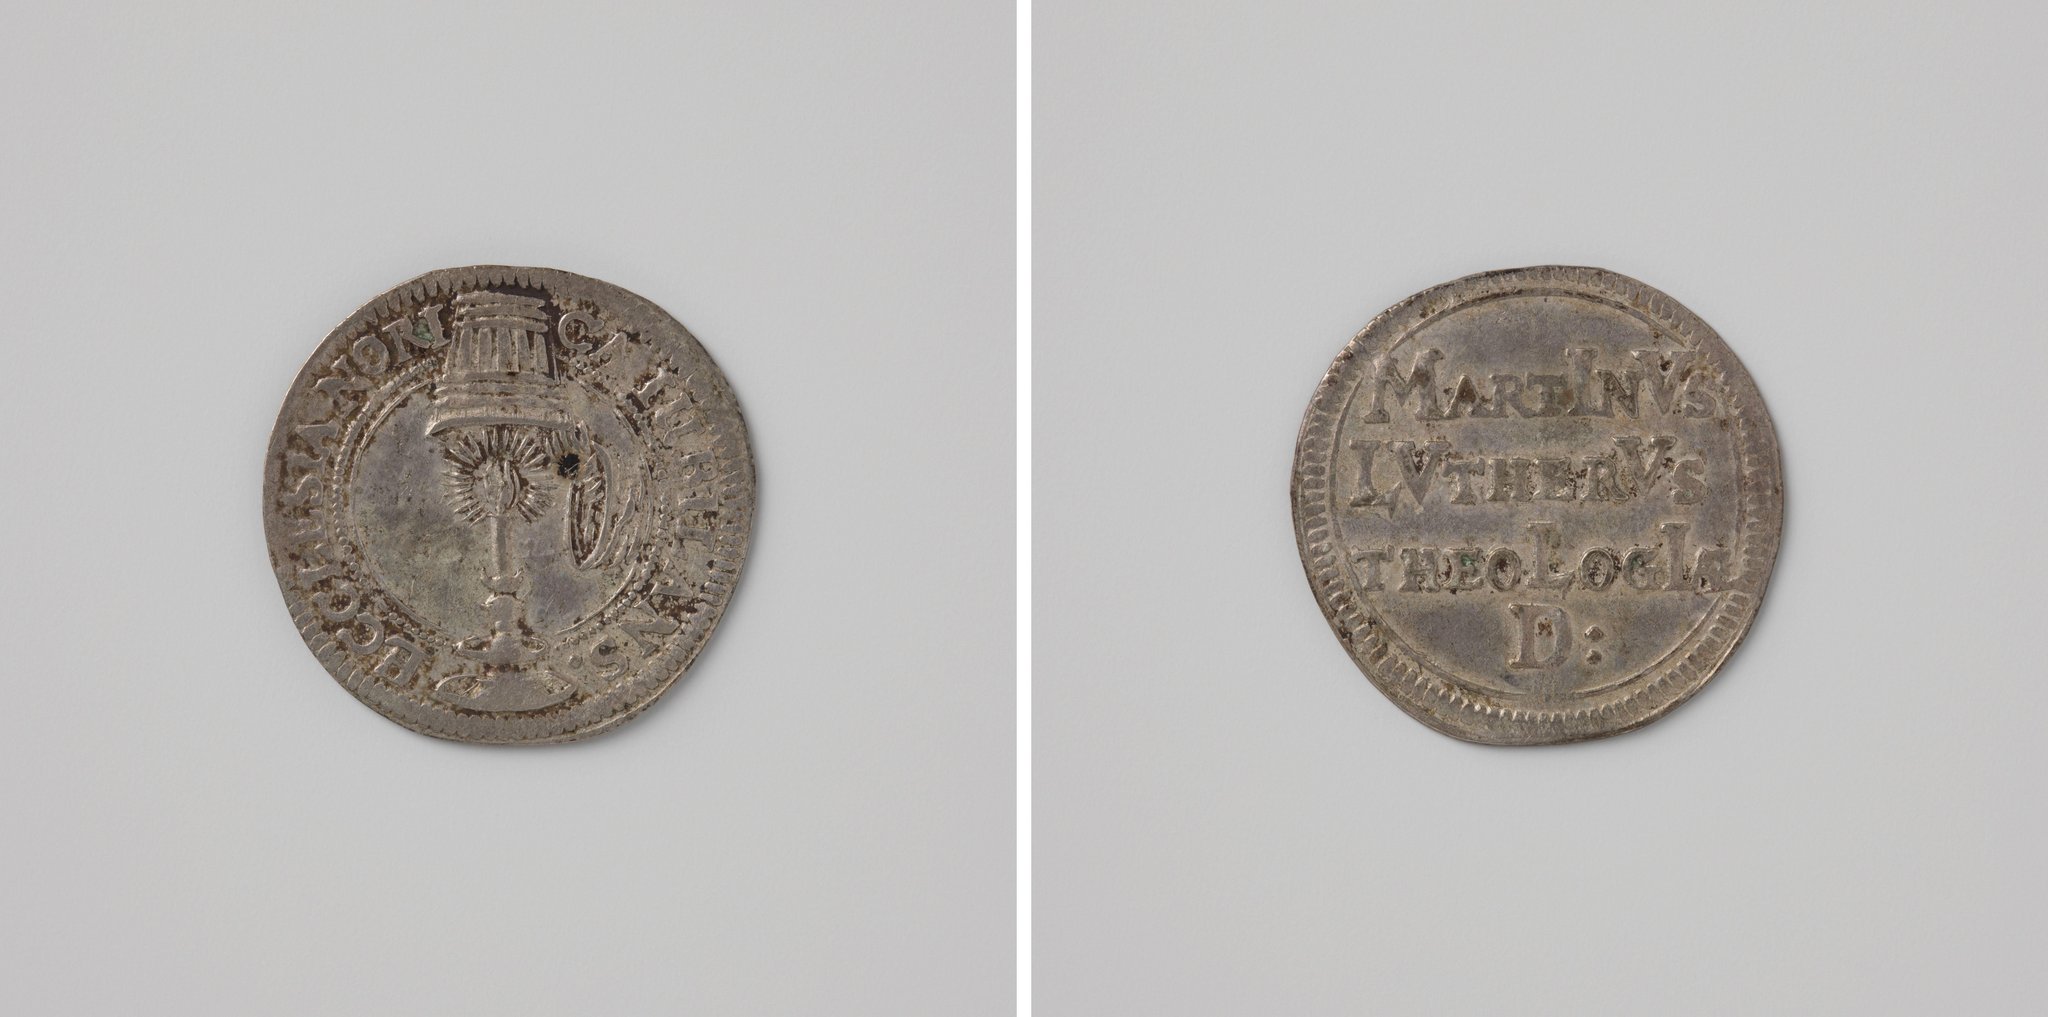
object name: history medal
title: Eerste eeuwfeest van de Reformatie door Martin Luther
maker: Anonymous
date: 1617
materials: silver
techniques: striking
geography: germany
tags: priest, martin luther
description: Zilveren penning. Voorzijde: hand die een korenmaat van een brandende kaars weghaalt binnen omschrift. Keerzijde: opschrift